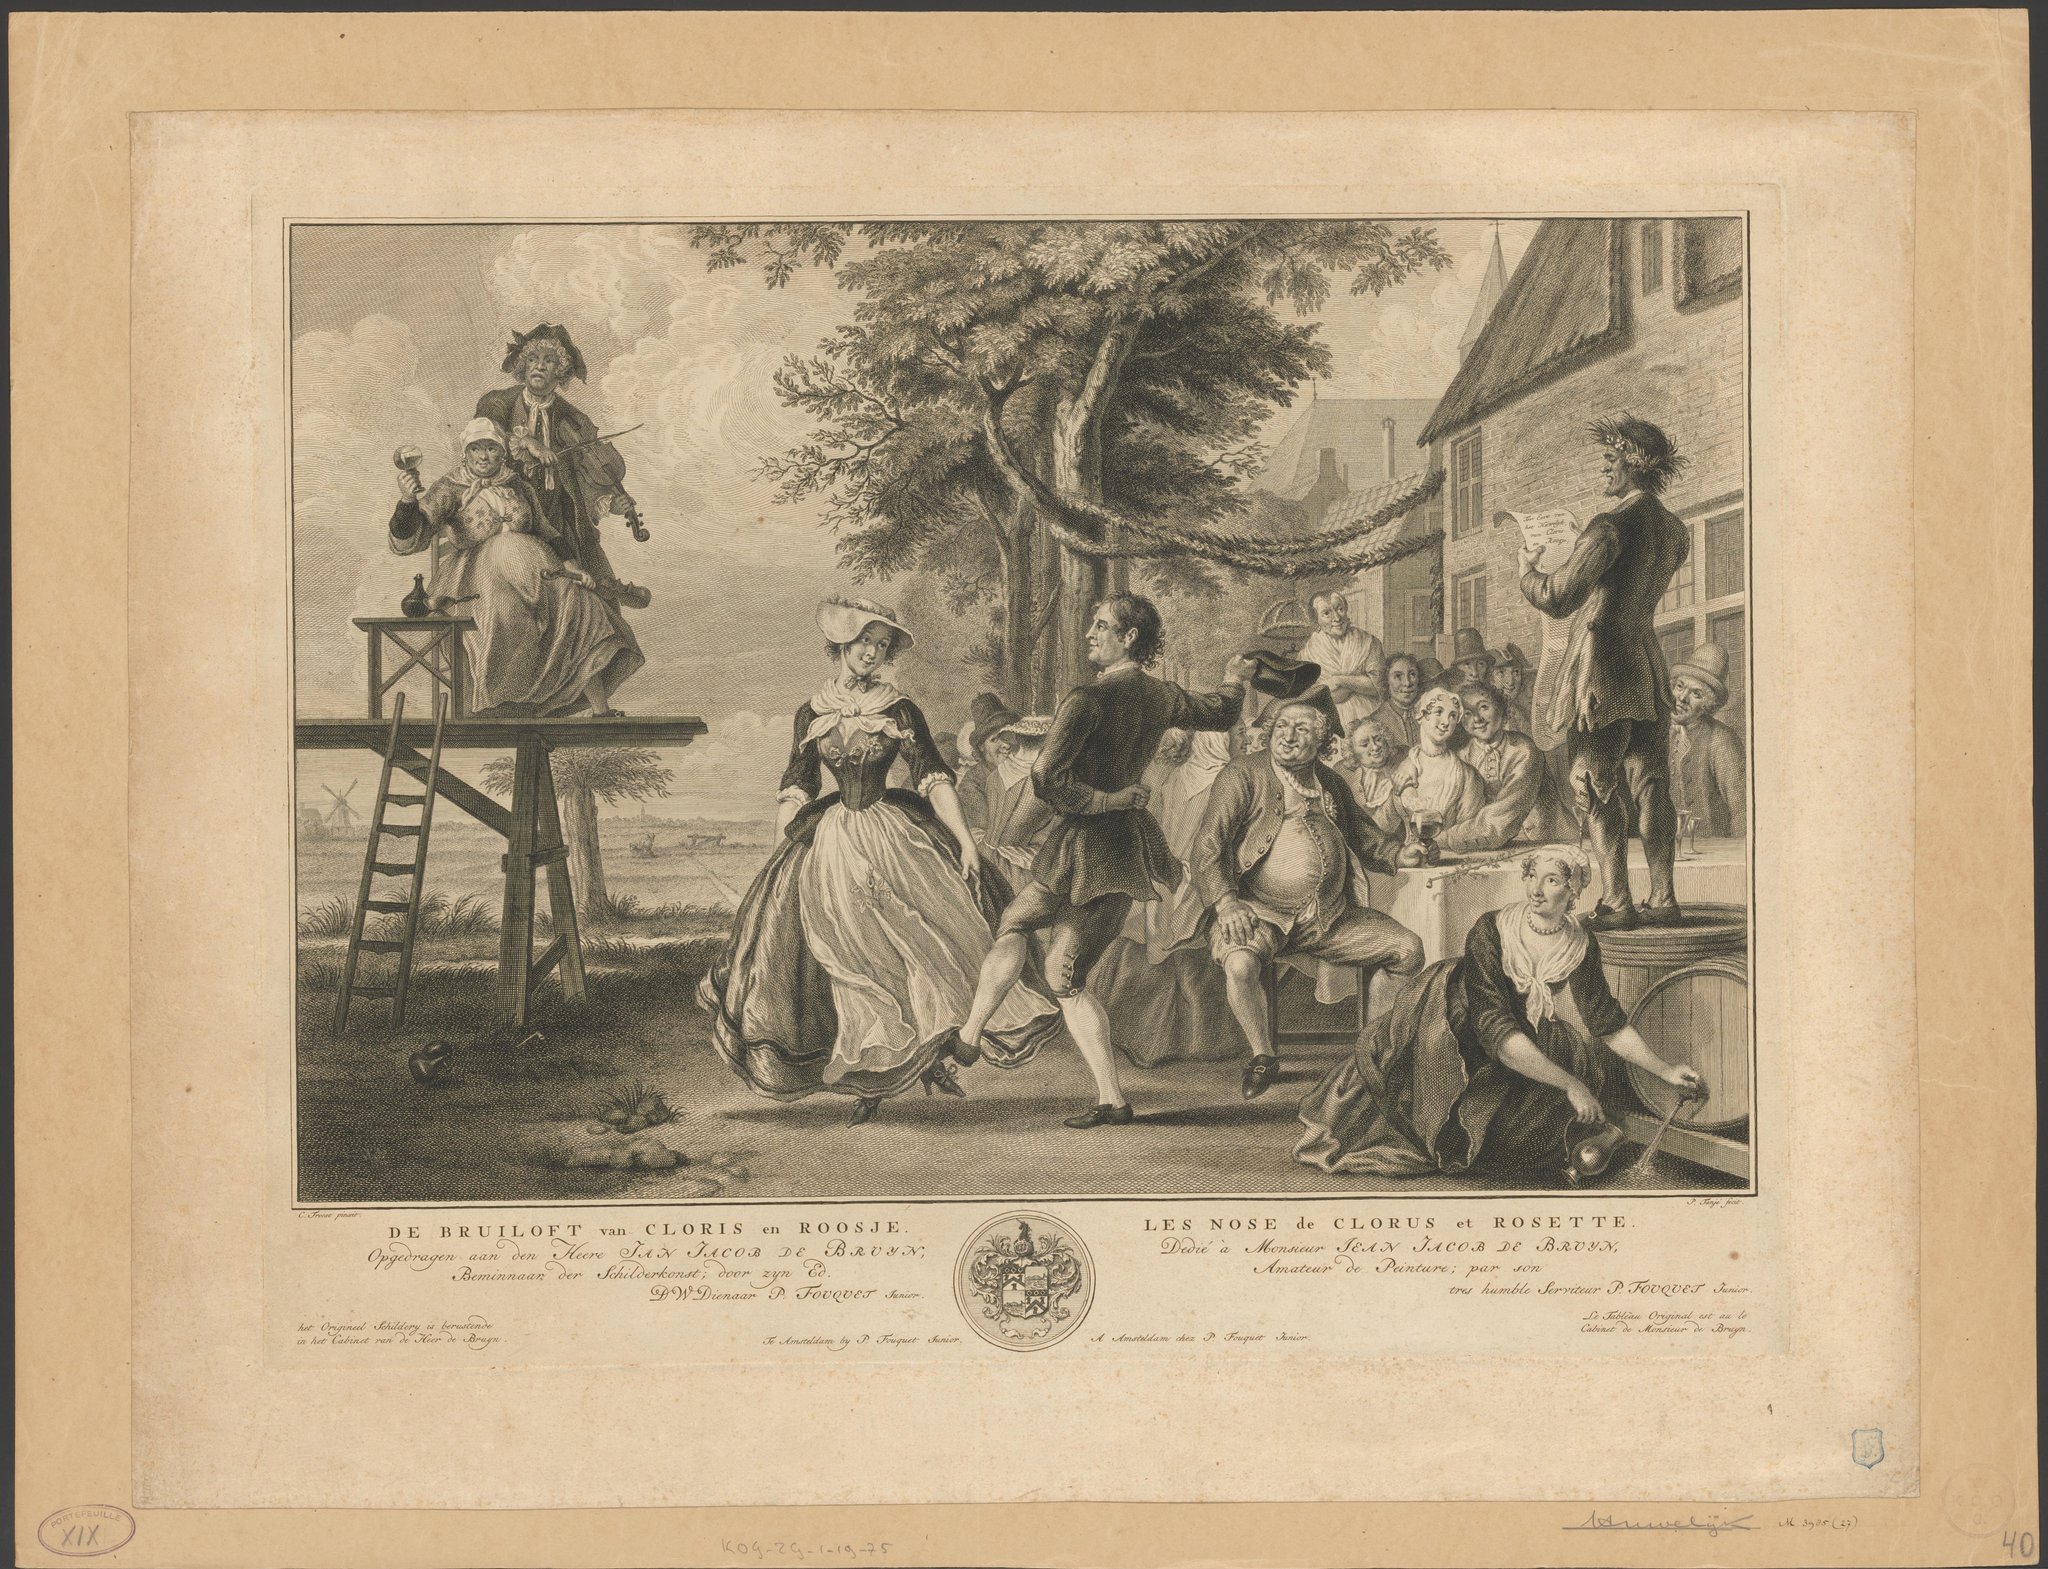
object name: print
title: Bruiloft van Cloris en Roosje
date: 1752-1761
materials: paper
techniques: engraving, etching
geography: amsterdam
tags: violin, fiddle, dancing at wedding feast - dd - out of doors, amsterdam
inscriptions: collector's mark: Lugt 1641, collector's mark, collector's mark: Lugt 963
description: Cloris en Roosje dansen op hun bruiloft. Op de verhoging twee vioolspelers, van wie de vrouw het glas heft. Rechts de feestgangers en een man, die vanaf een ton een toespraak houdt. Onderaan in de marge het wapenschild van en een opdracht aan Jan Jacob de Bruyn, die het originele schilderij in zijn verzameling had. Scène uit het zangspel De bruiloft van Cloris en Roosje. Onderwerpsrubrieken binnen de Atlas Zeden en Gewoonten: Des Menschen Begin, Midden en Einde. Bruiloft en huwelijk.